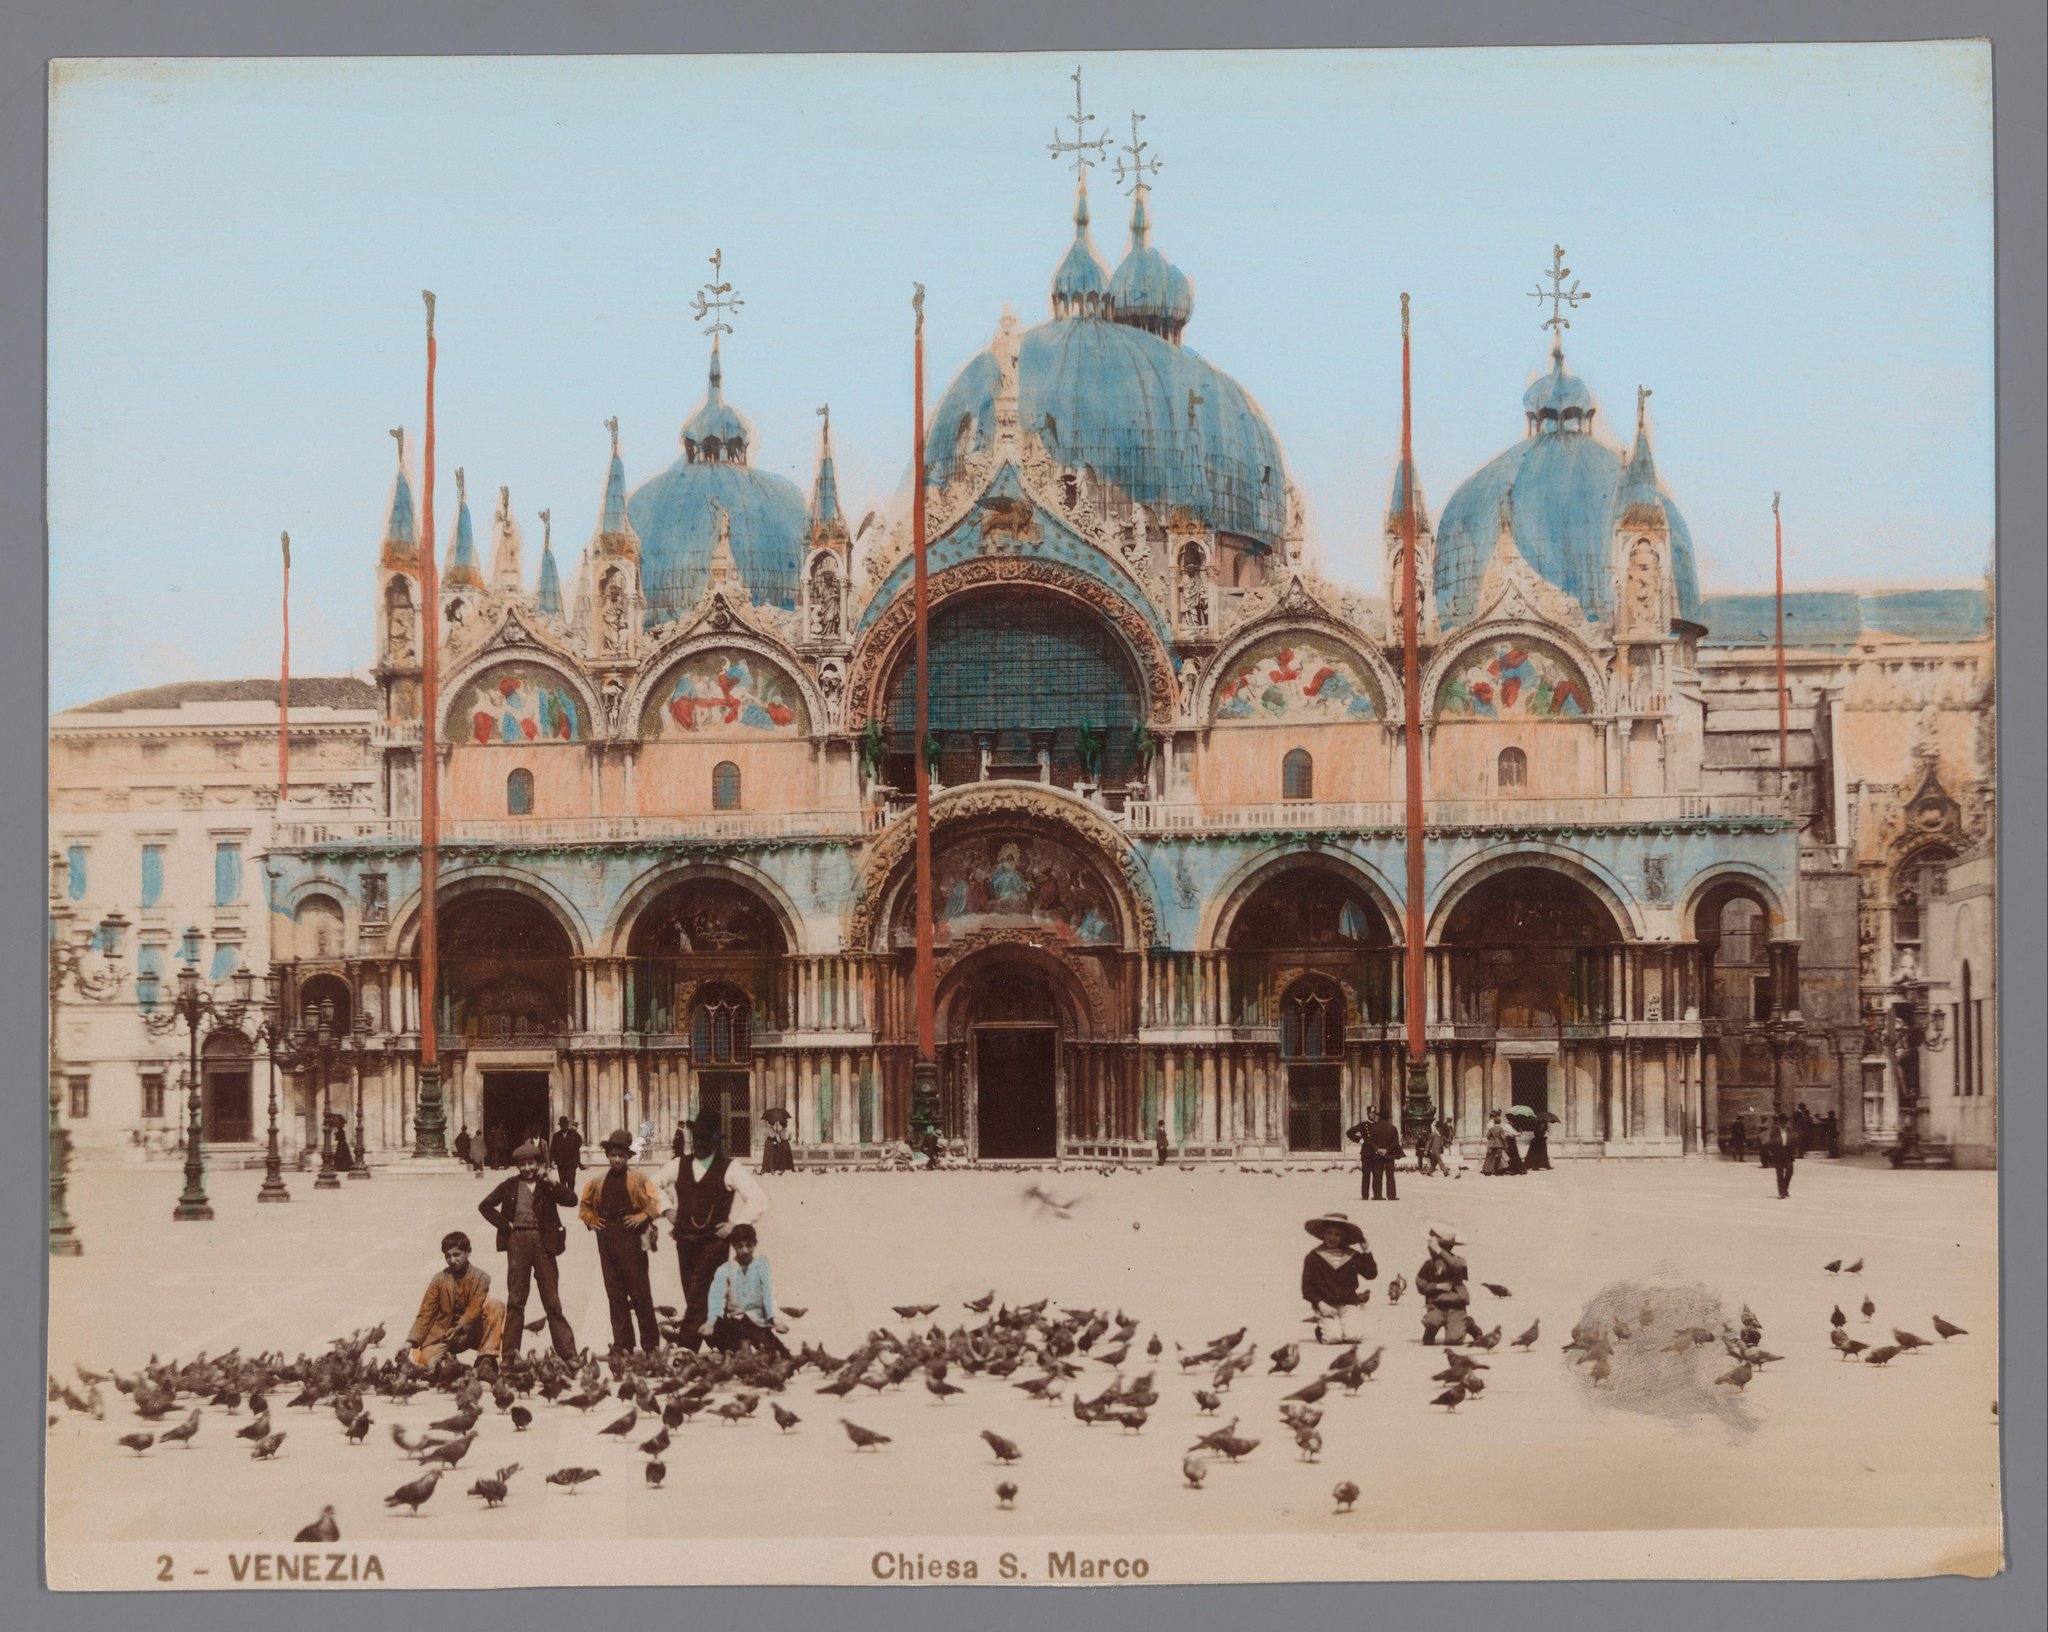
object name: photograph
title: Venezia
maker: Anonymous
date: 1851-1900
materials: paper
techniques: albumen print, hand coloring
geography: venice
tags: church (exterior), doves, pigeons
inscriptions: number: ‘2’